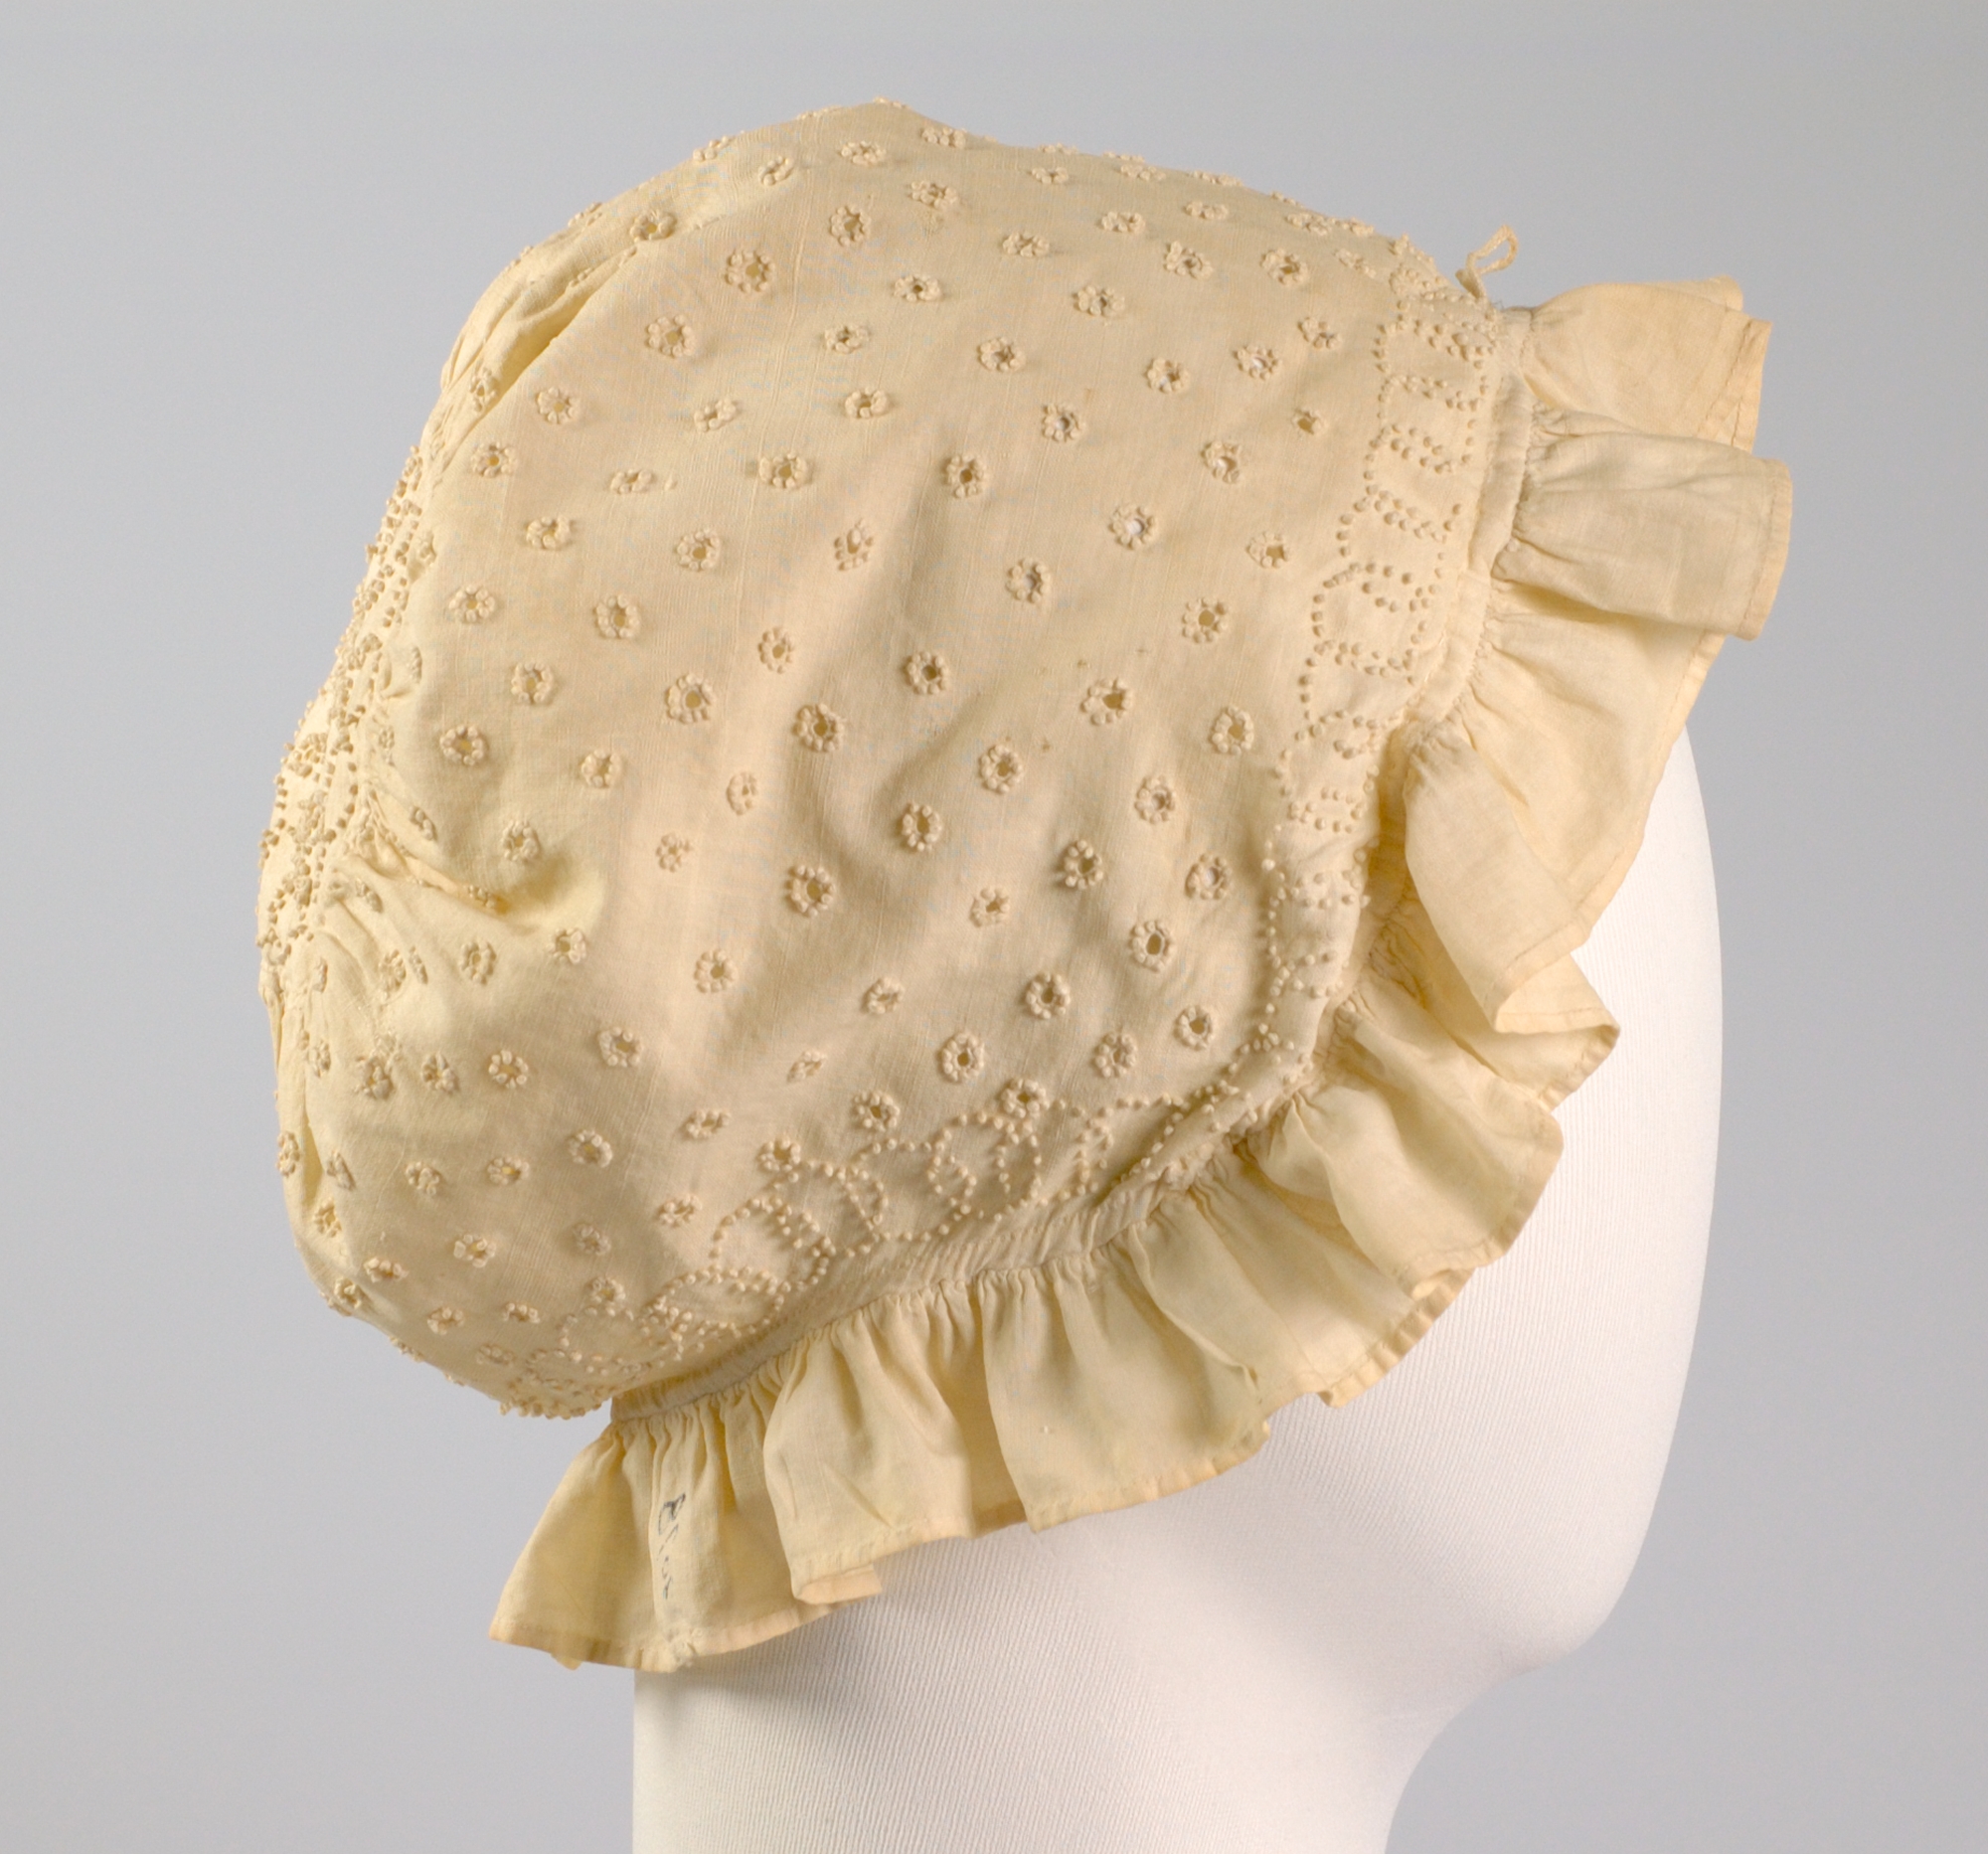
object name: cap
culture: american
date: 1820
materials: cotton